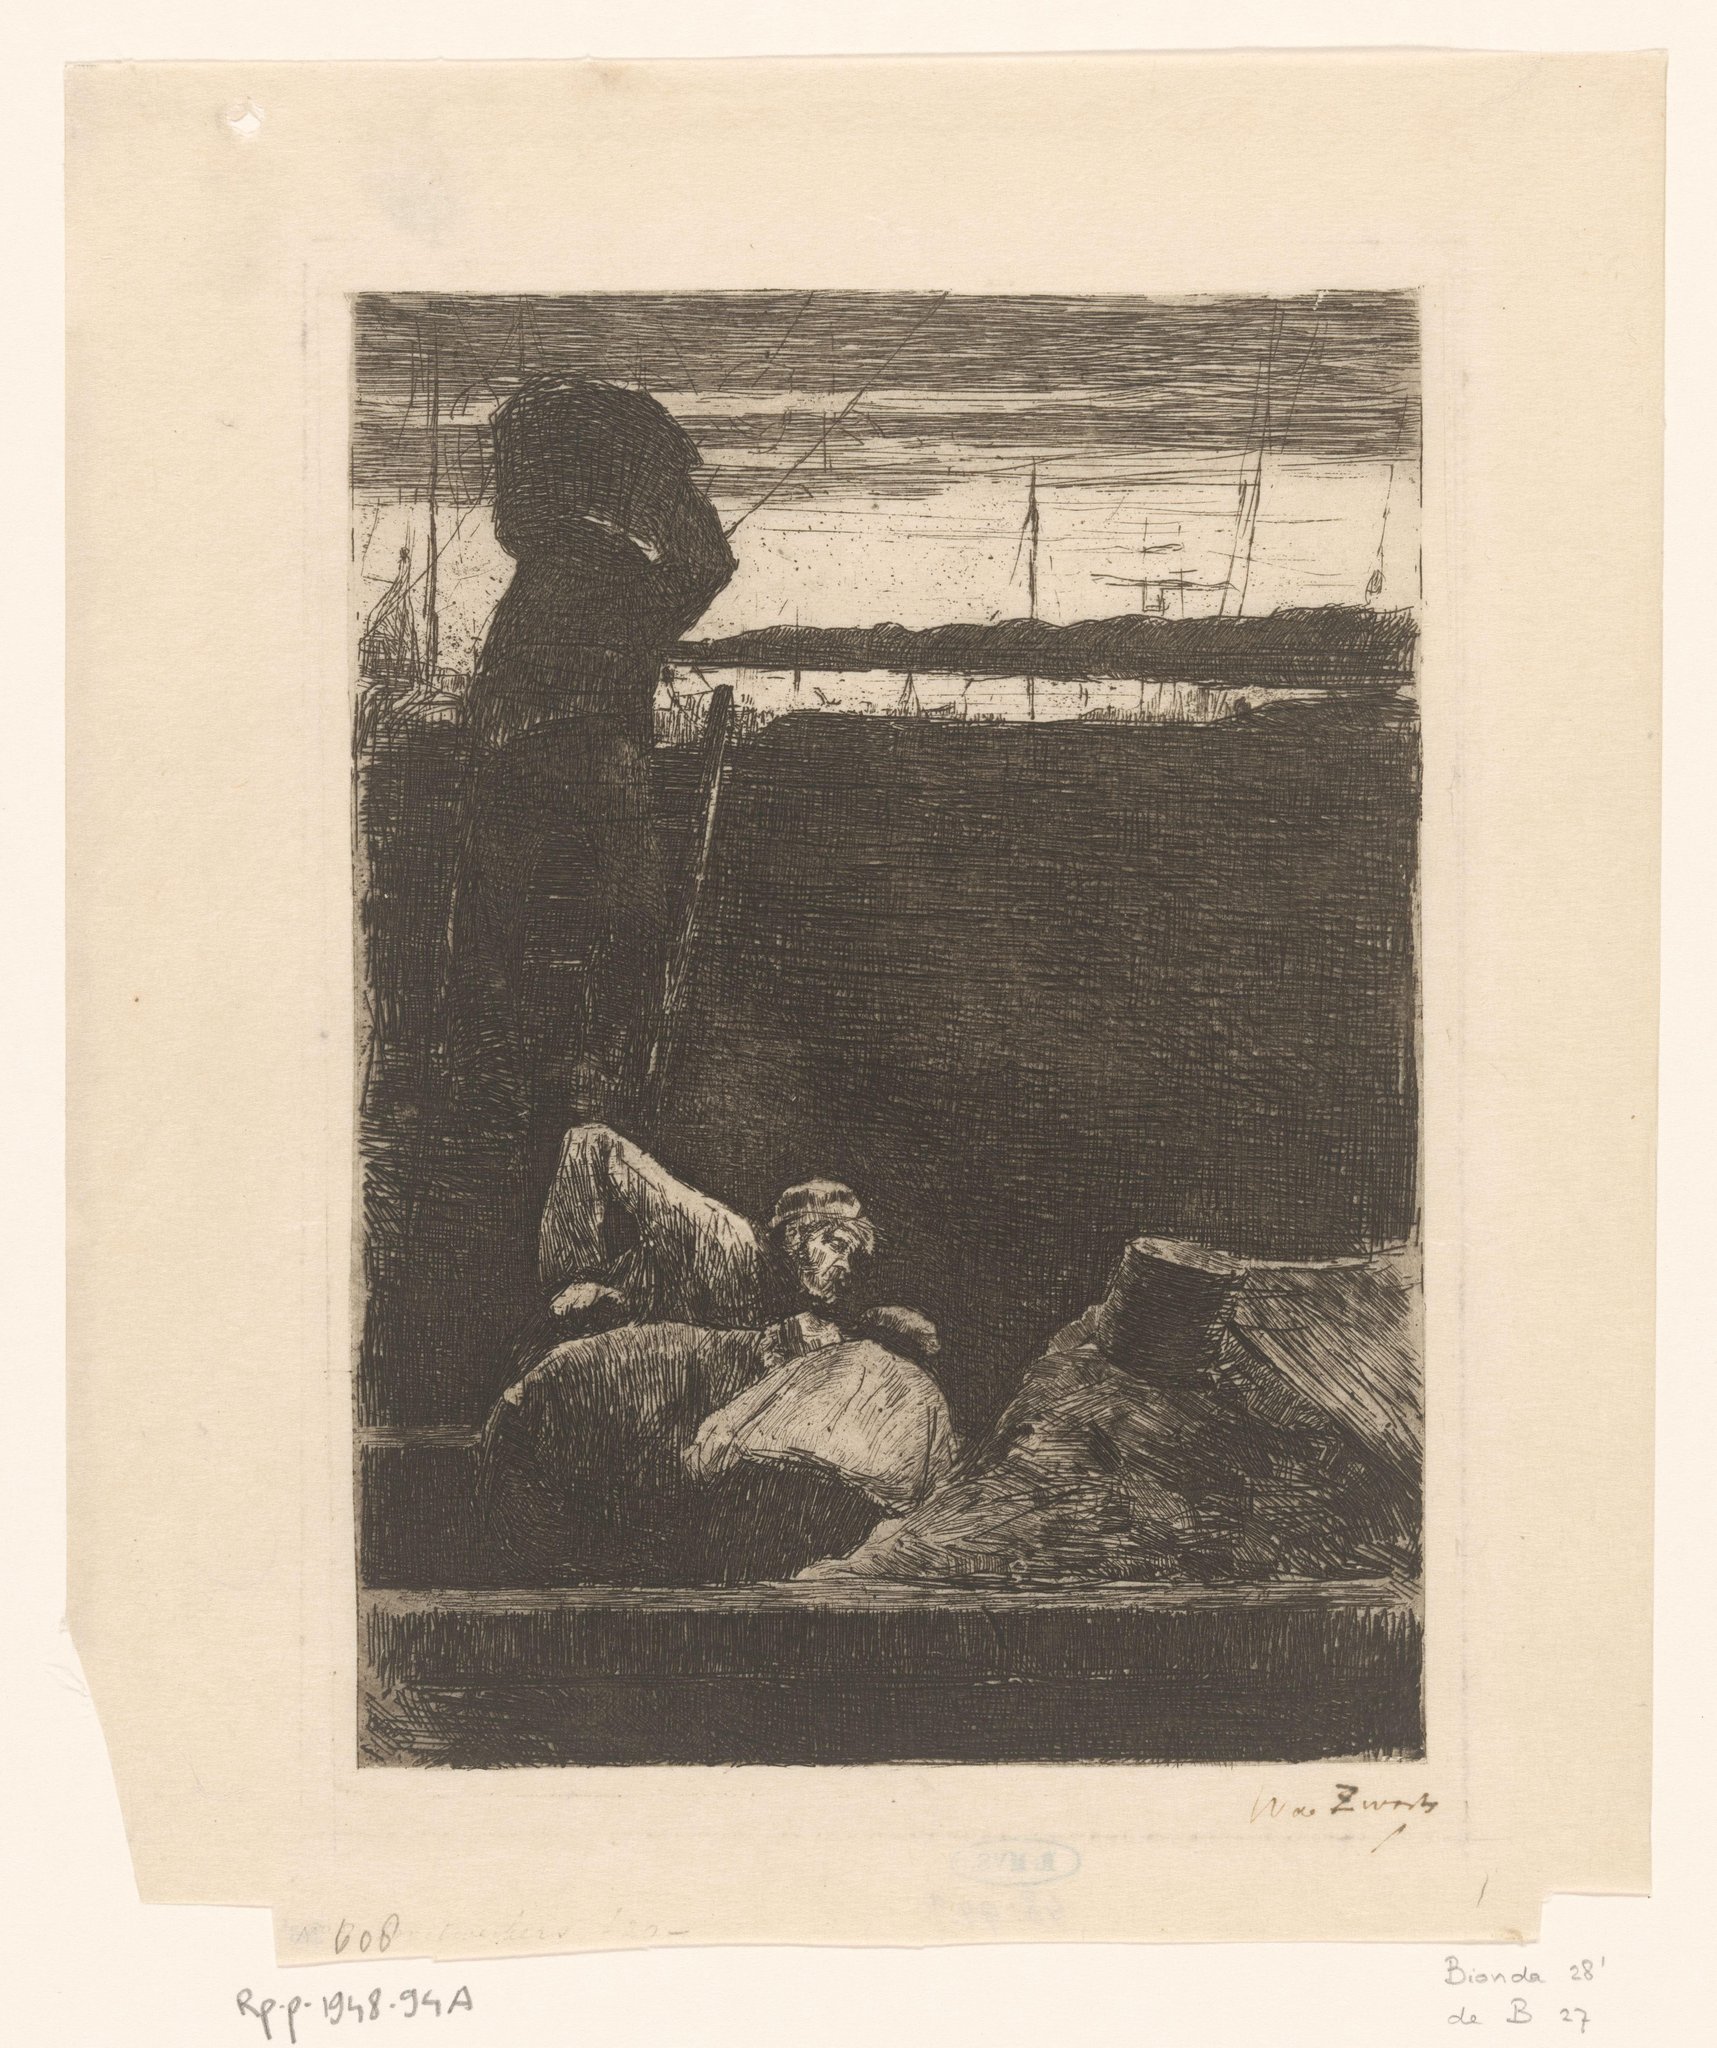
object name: print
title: Kolendragers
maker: willem de zwart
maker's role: draughtsman, painter, print maker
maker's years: 1862-1931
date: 1886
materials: paper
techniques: drypoint, etching, intaglio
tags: harbour, coal-shovel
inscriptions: collector's mark: Lugt 2228